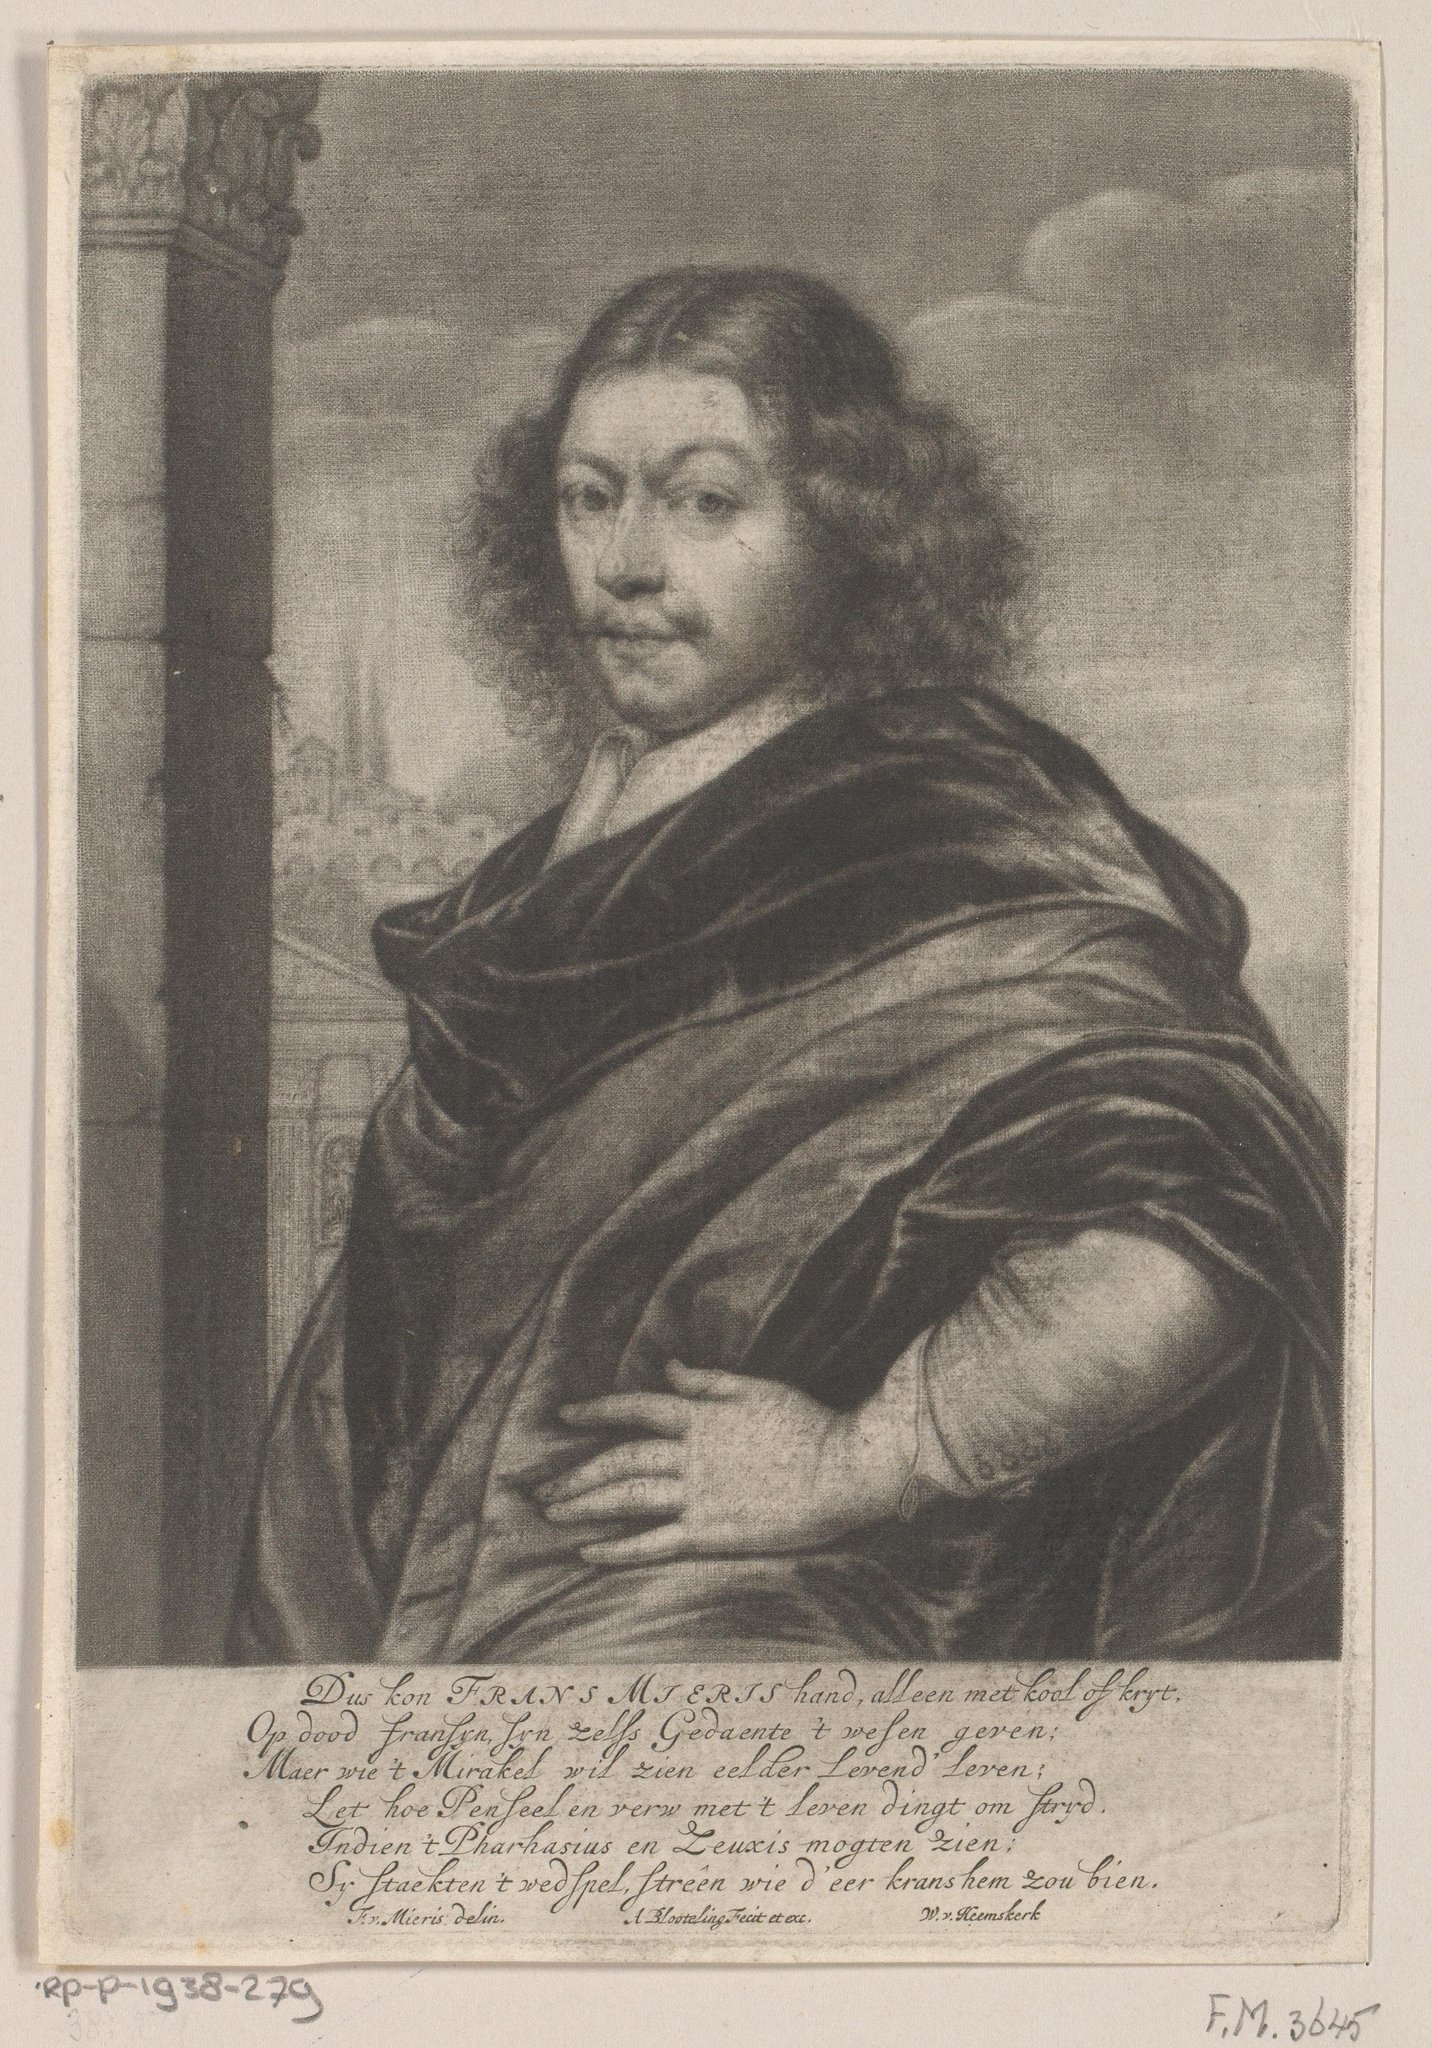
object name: print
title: Portret van Frans van Mieris (I)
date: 1655-1690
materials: paper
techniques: mezzotint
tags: leiden, painter, print maker, draughtsman, frans van mieris (i), historical persons, portrait, self-portrait of painter, artist in non-work situation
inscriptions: collector's mark: Lugt 2228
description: Met zesregelig onderschrift in het Nederlands.